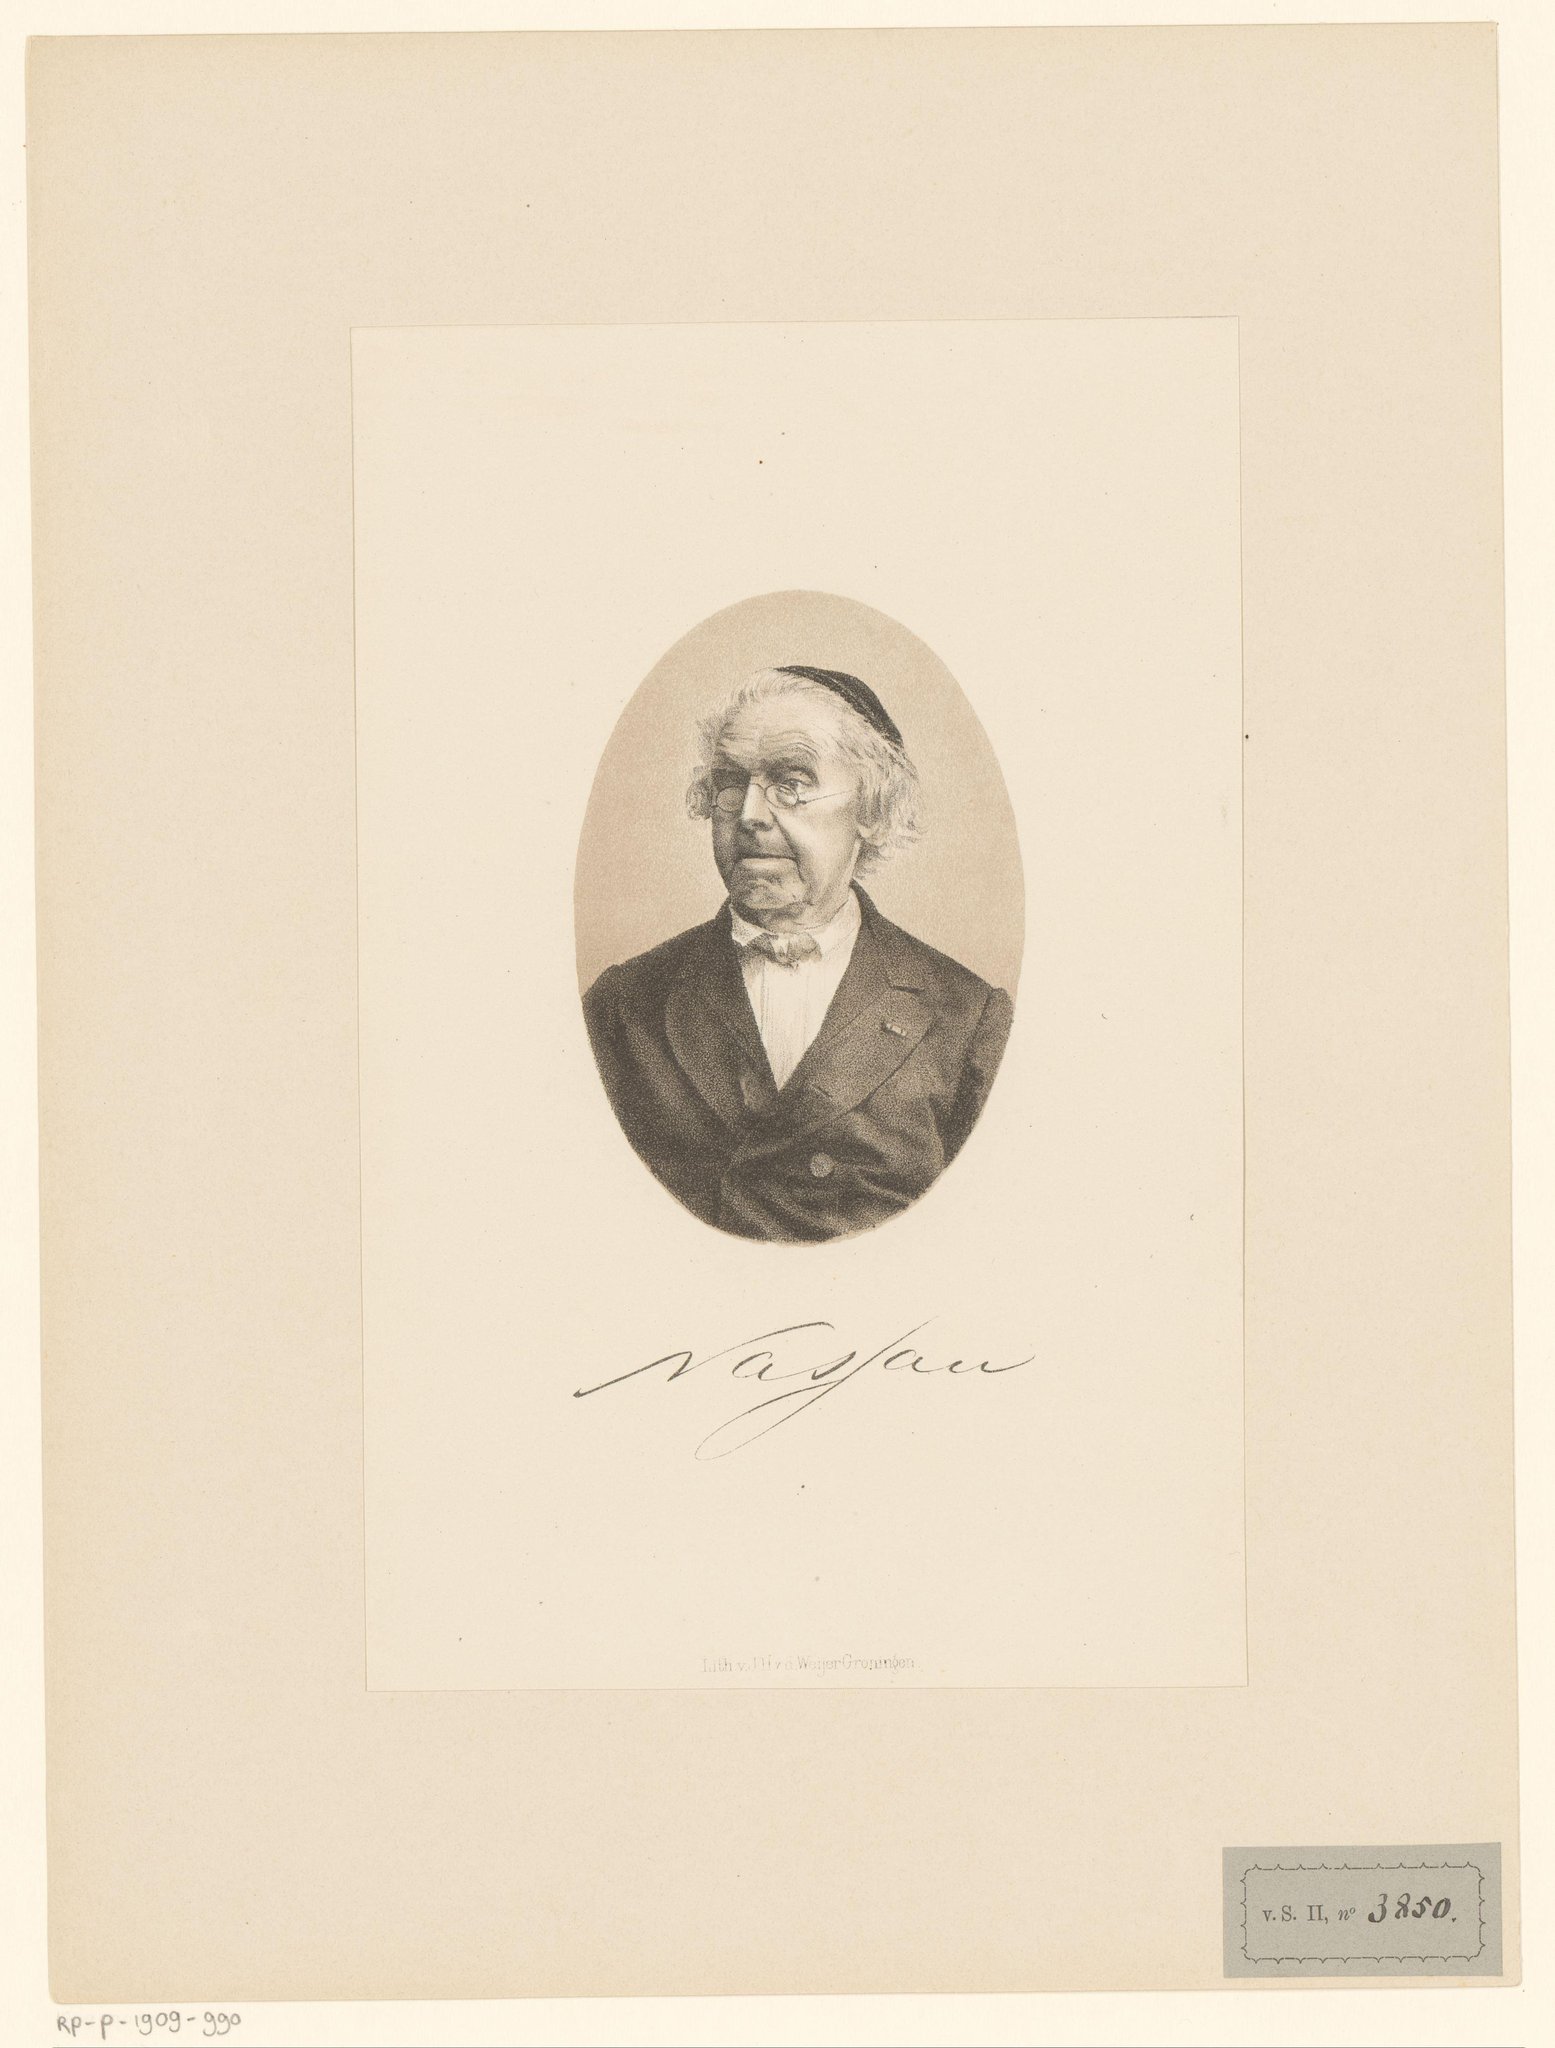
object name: print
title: Portret van Hendrik Jan Nassau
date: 1876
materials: paper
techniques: tone lithography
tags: middelburg, eyeglasses, spectacles, historical persons (+ (full) bust portrait)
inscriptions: collector's mark: Lugt 2228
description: Onder het portret de signatuur van de geportretteerde.